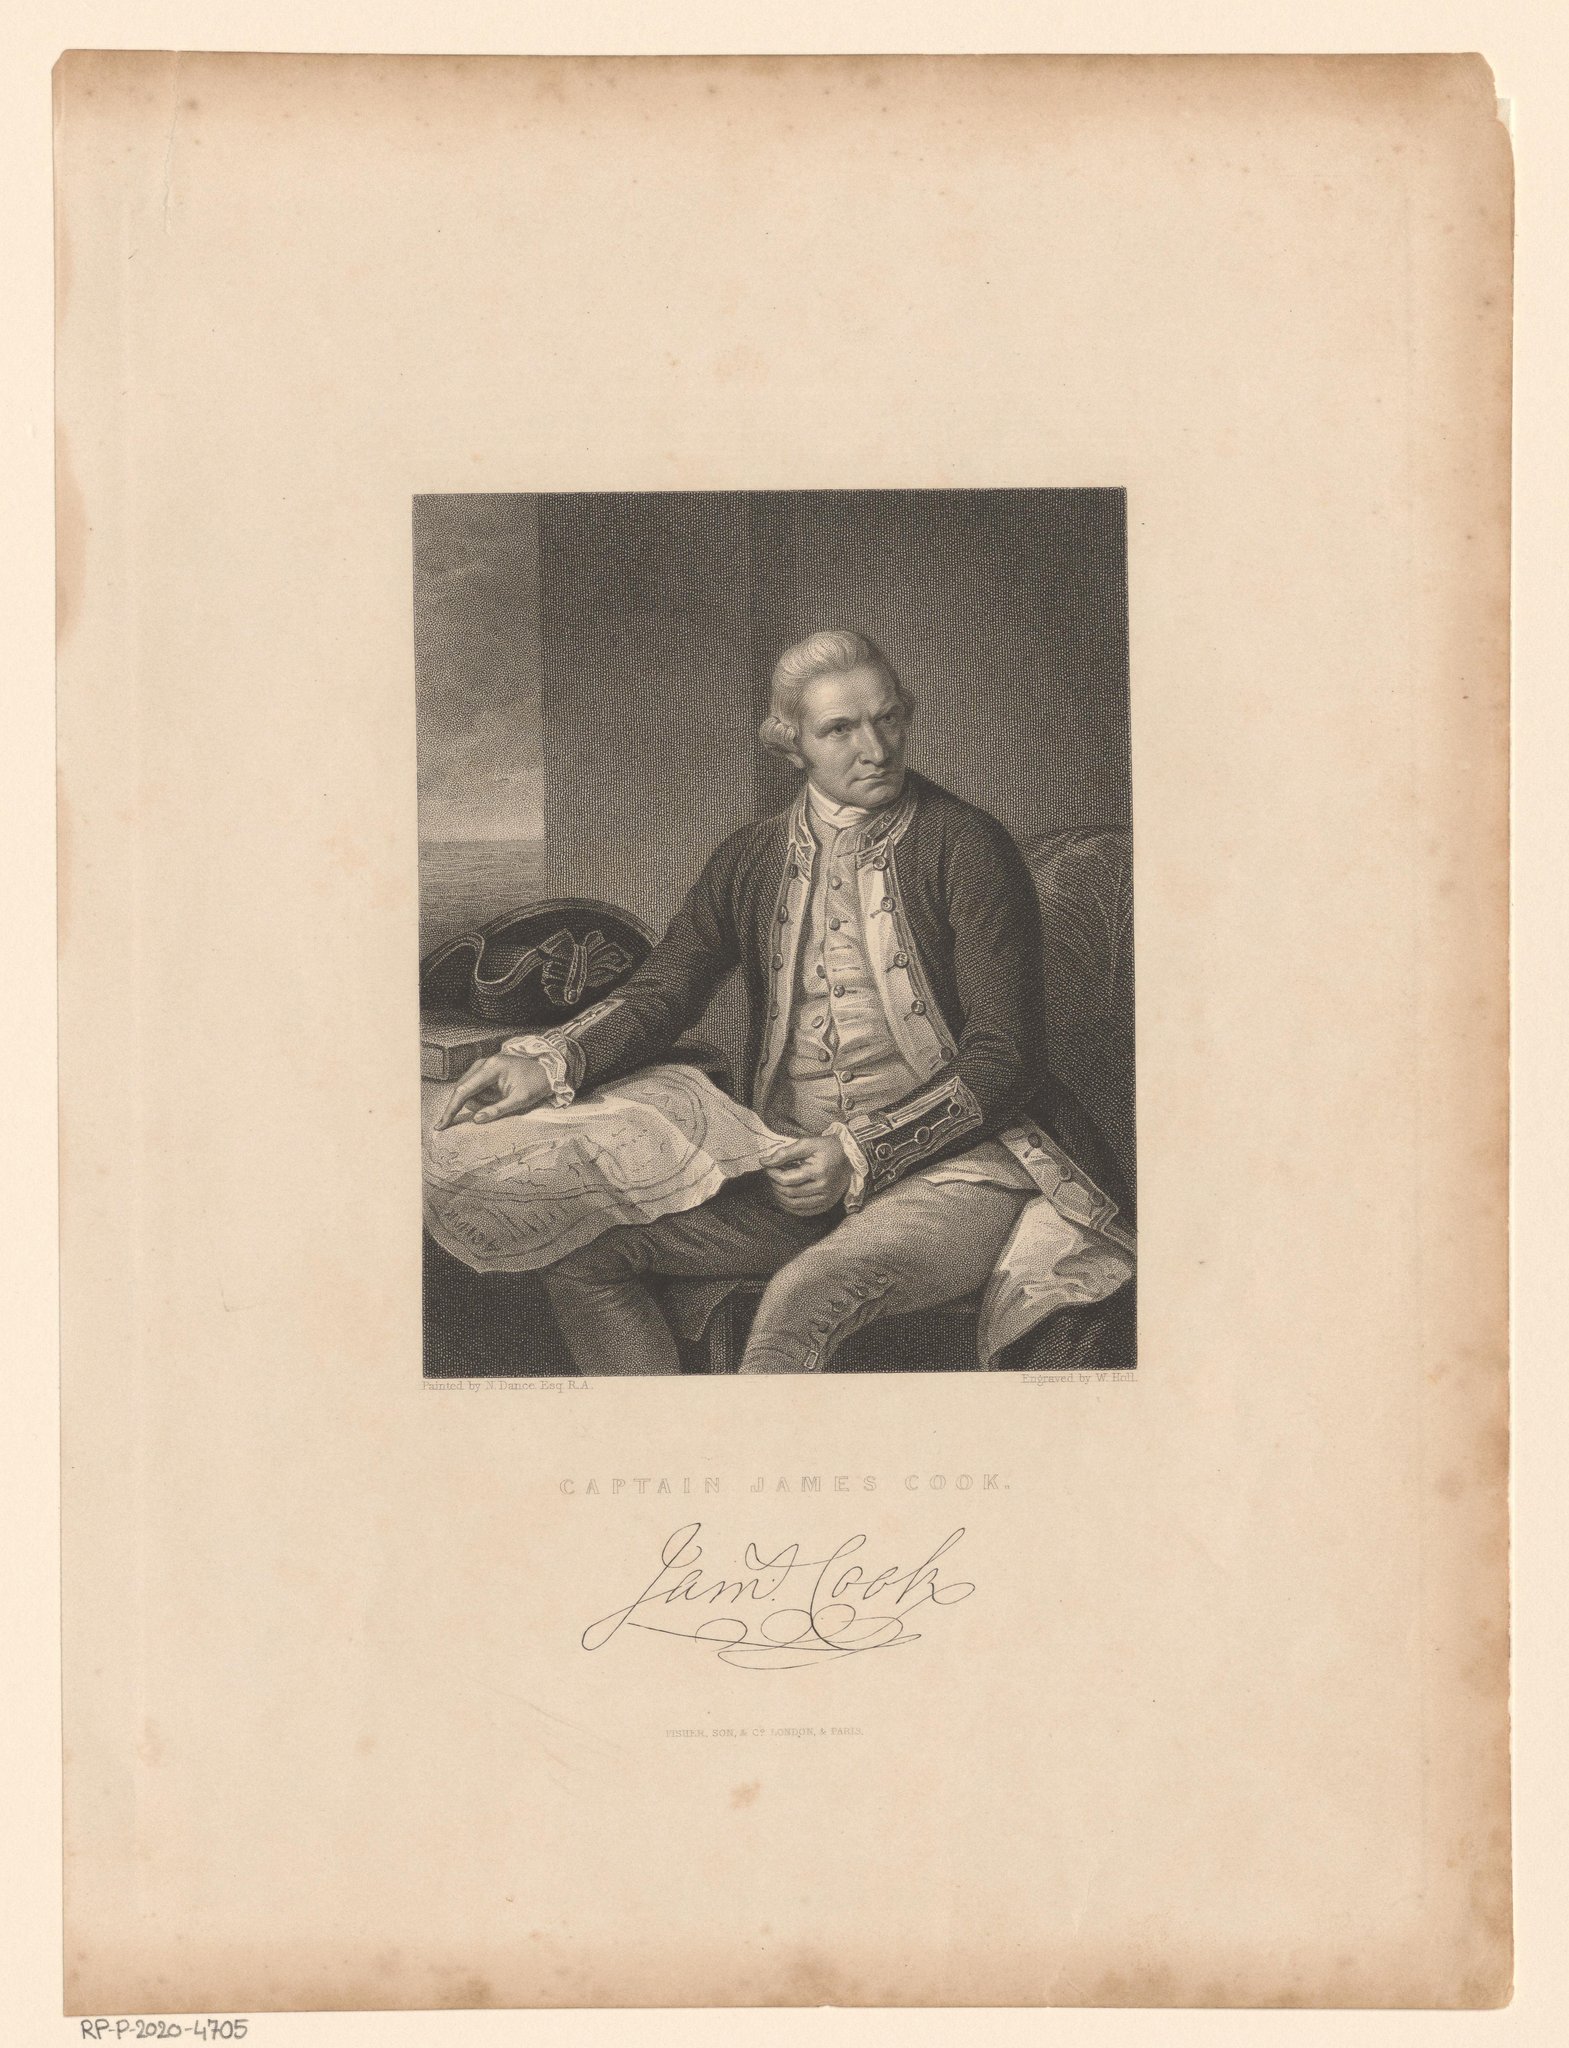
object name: print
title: Portret van James Cook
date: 1821-1848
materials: paper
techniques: etching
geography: london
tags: james cook, historical persons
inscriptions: collector's mark: Lugt 2228